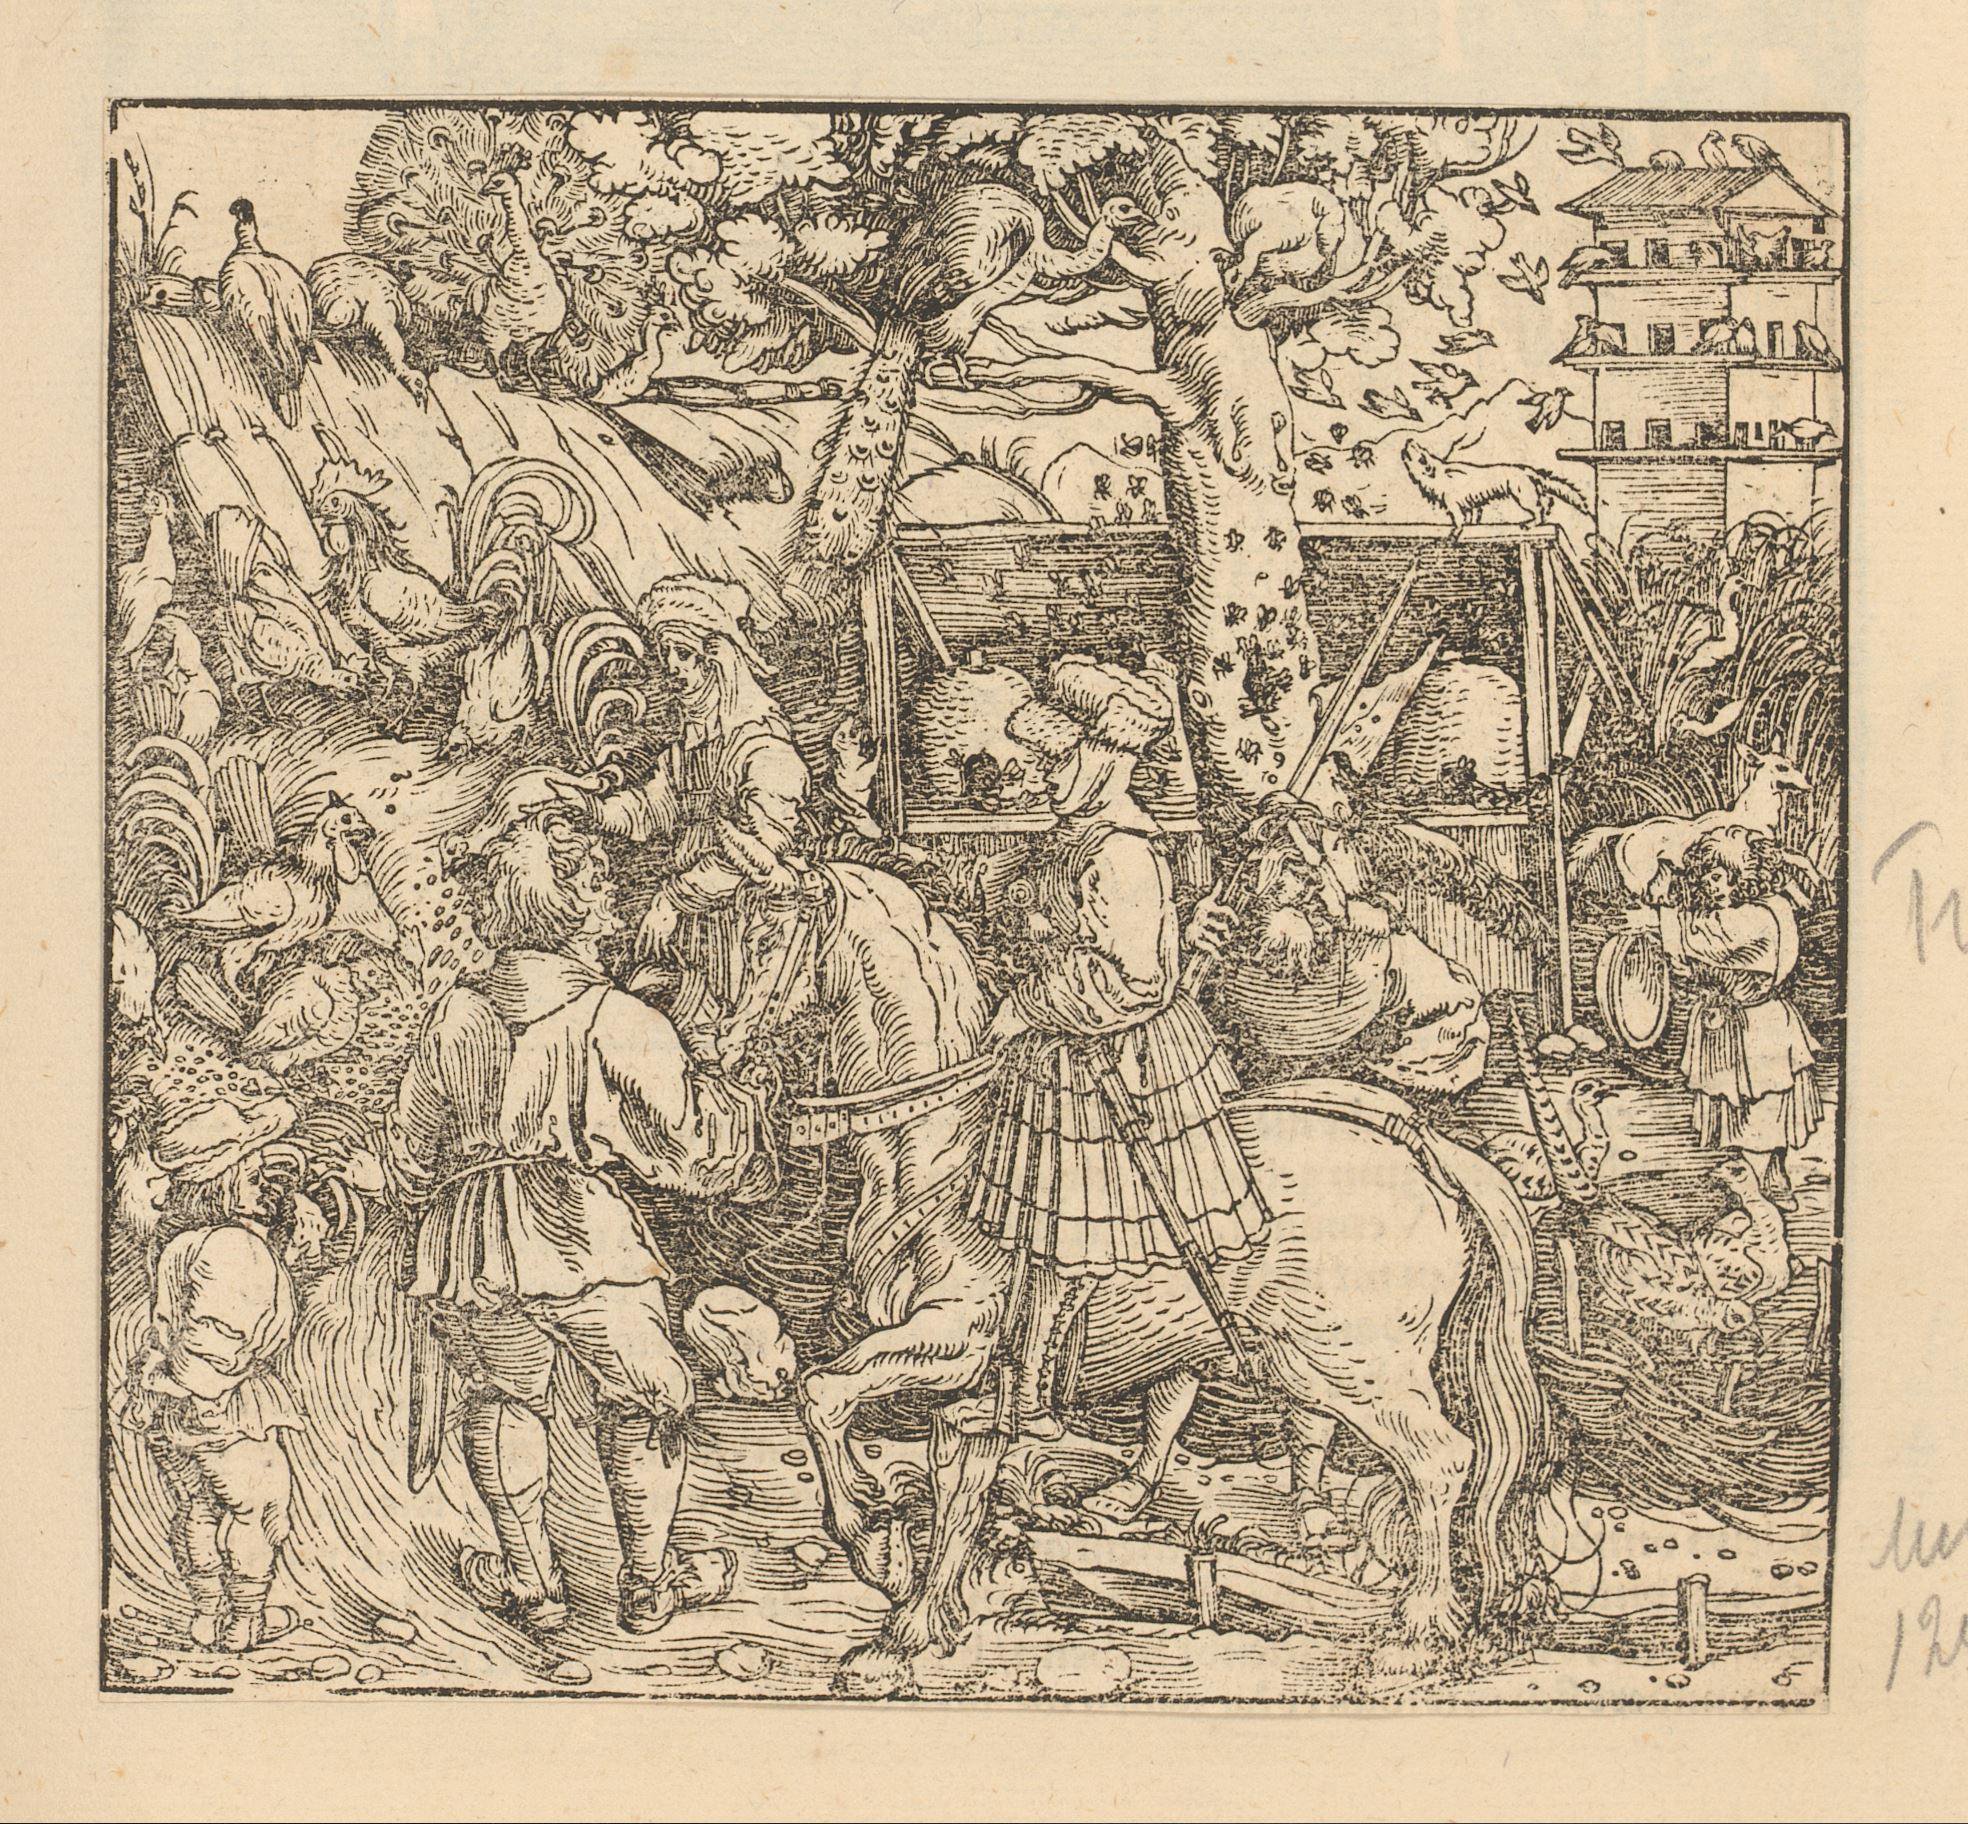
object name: book illustration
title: Ruiter bij een pluimveehouderij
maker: Anonymous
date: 1514-1532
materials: paper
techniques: letterpress printing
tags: poultry farm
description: Deze prent is gebruikt in: Petrarca, Francesco. Von der Artzney bayder Glück, des guten und widerwertigen: unnd weß sich ain yeder inn Gelück und Unglück halten sol (...). Augsburg: Heinrich Steiner, 1532. Deze uitgave is ook bekend onder de titel 'Trostspiegel in Glück und Unglück'.